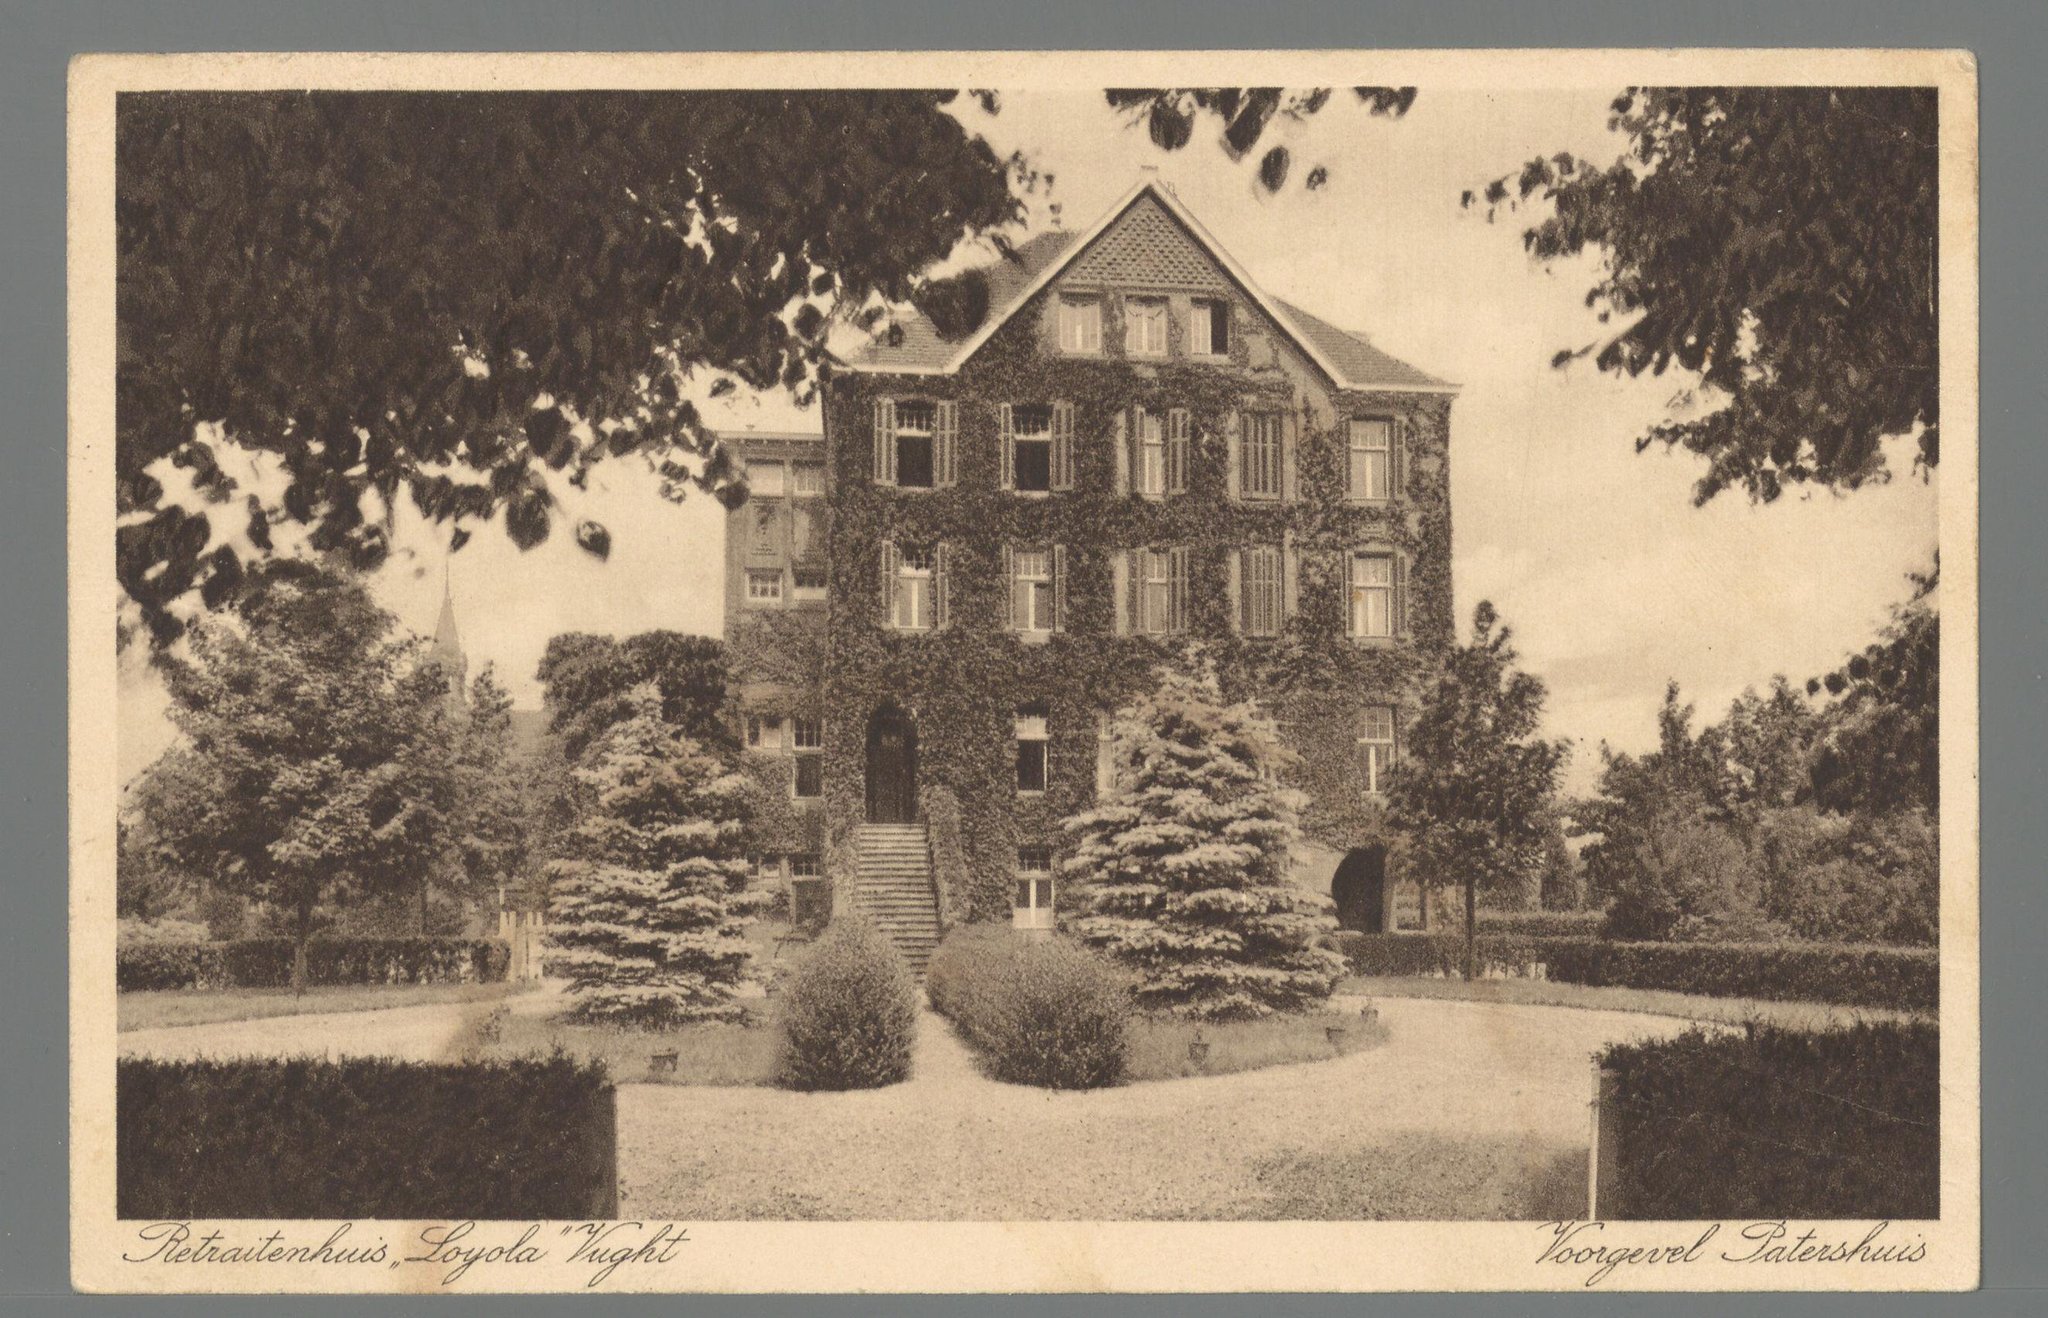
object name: photomechanical print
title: Retraitenhuis "Loyola" Vught. Voorgevel Patershuis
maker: Anonymous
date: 1913-1937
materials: cardboard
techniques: rotogravure, writing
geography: vught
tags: housing, regular clerics, e.g. jesuits, redemptorists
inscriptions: postage stamp